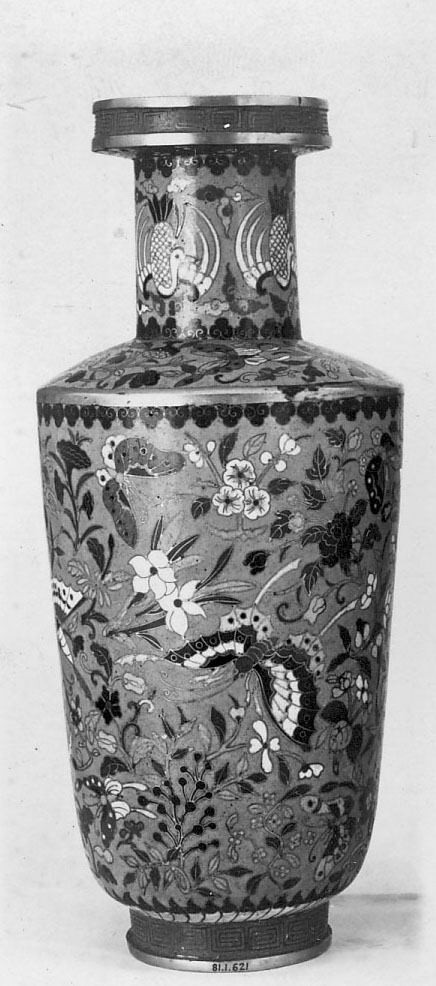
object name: vase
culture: chinese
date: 1701-1800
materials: copper, enamel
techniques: enamel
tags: birds,butterflies,flowers,plants